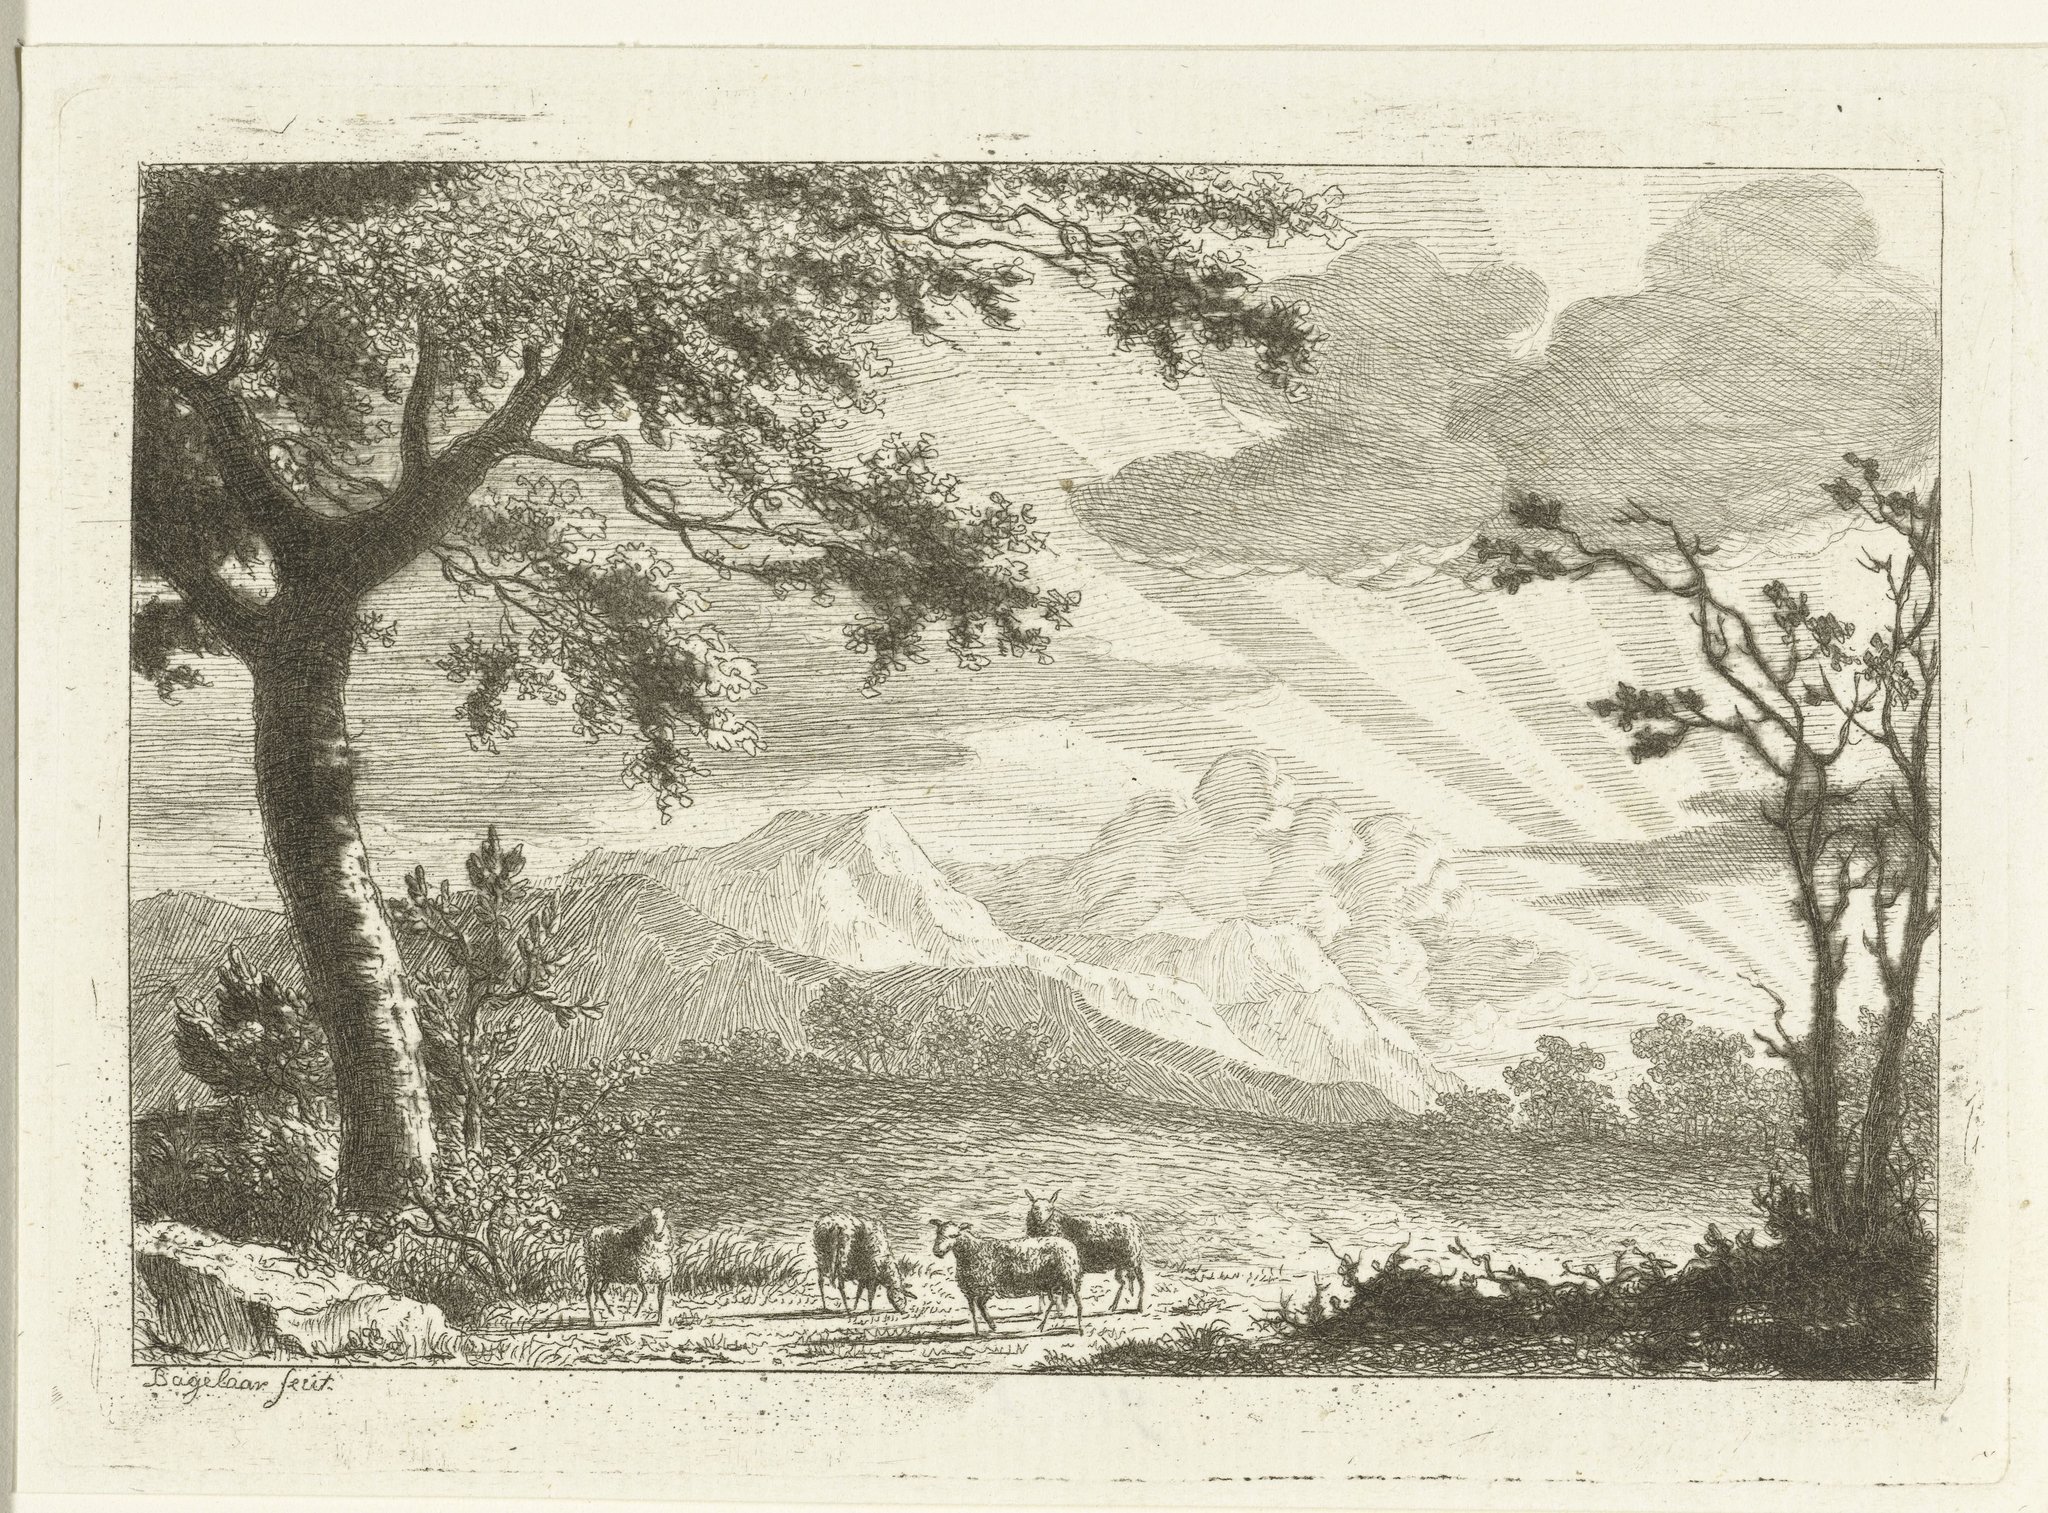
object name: print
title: Berglandschap met vier schapen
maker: ernst willem jan bagelaar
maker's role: draughtsman, print maker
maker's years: 1775-1837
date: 1798-1837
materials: paper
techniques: etching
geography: netherlands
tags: sheep, mountains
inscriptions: collector's mark: Lugt 2228